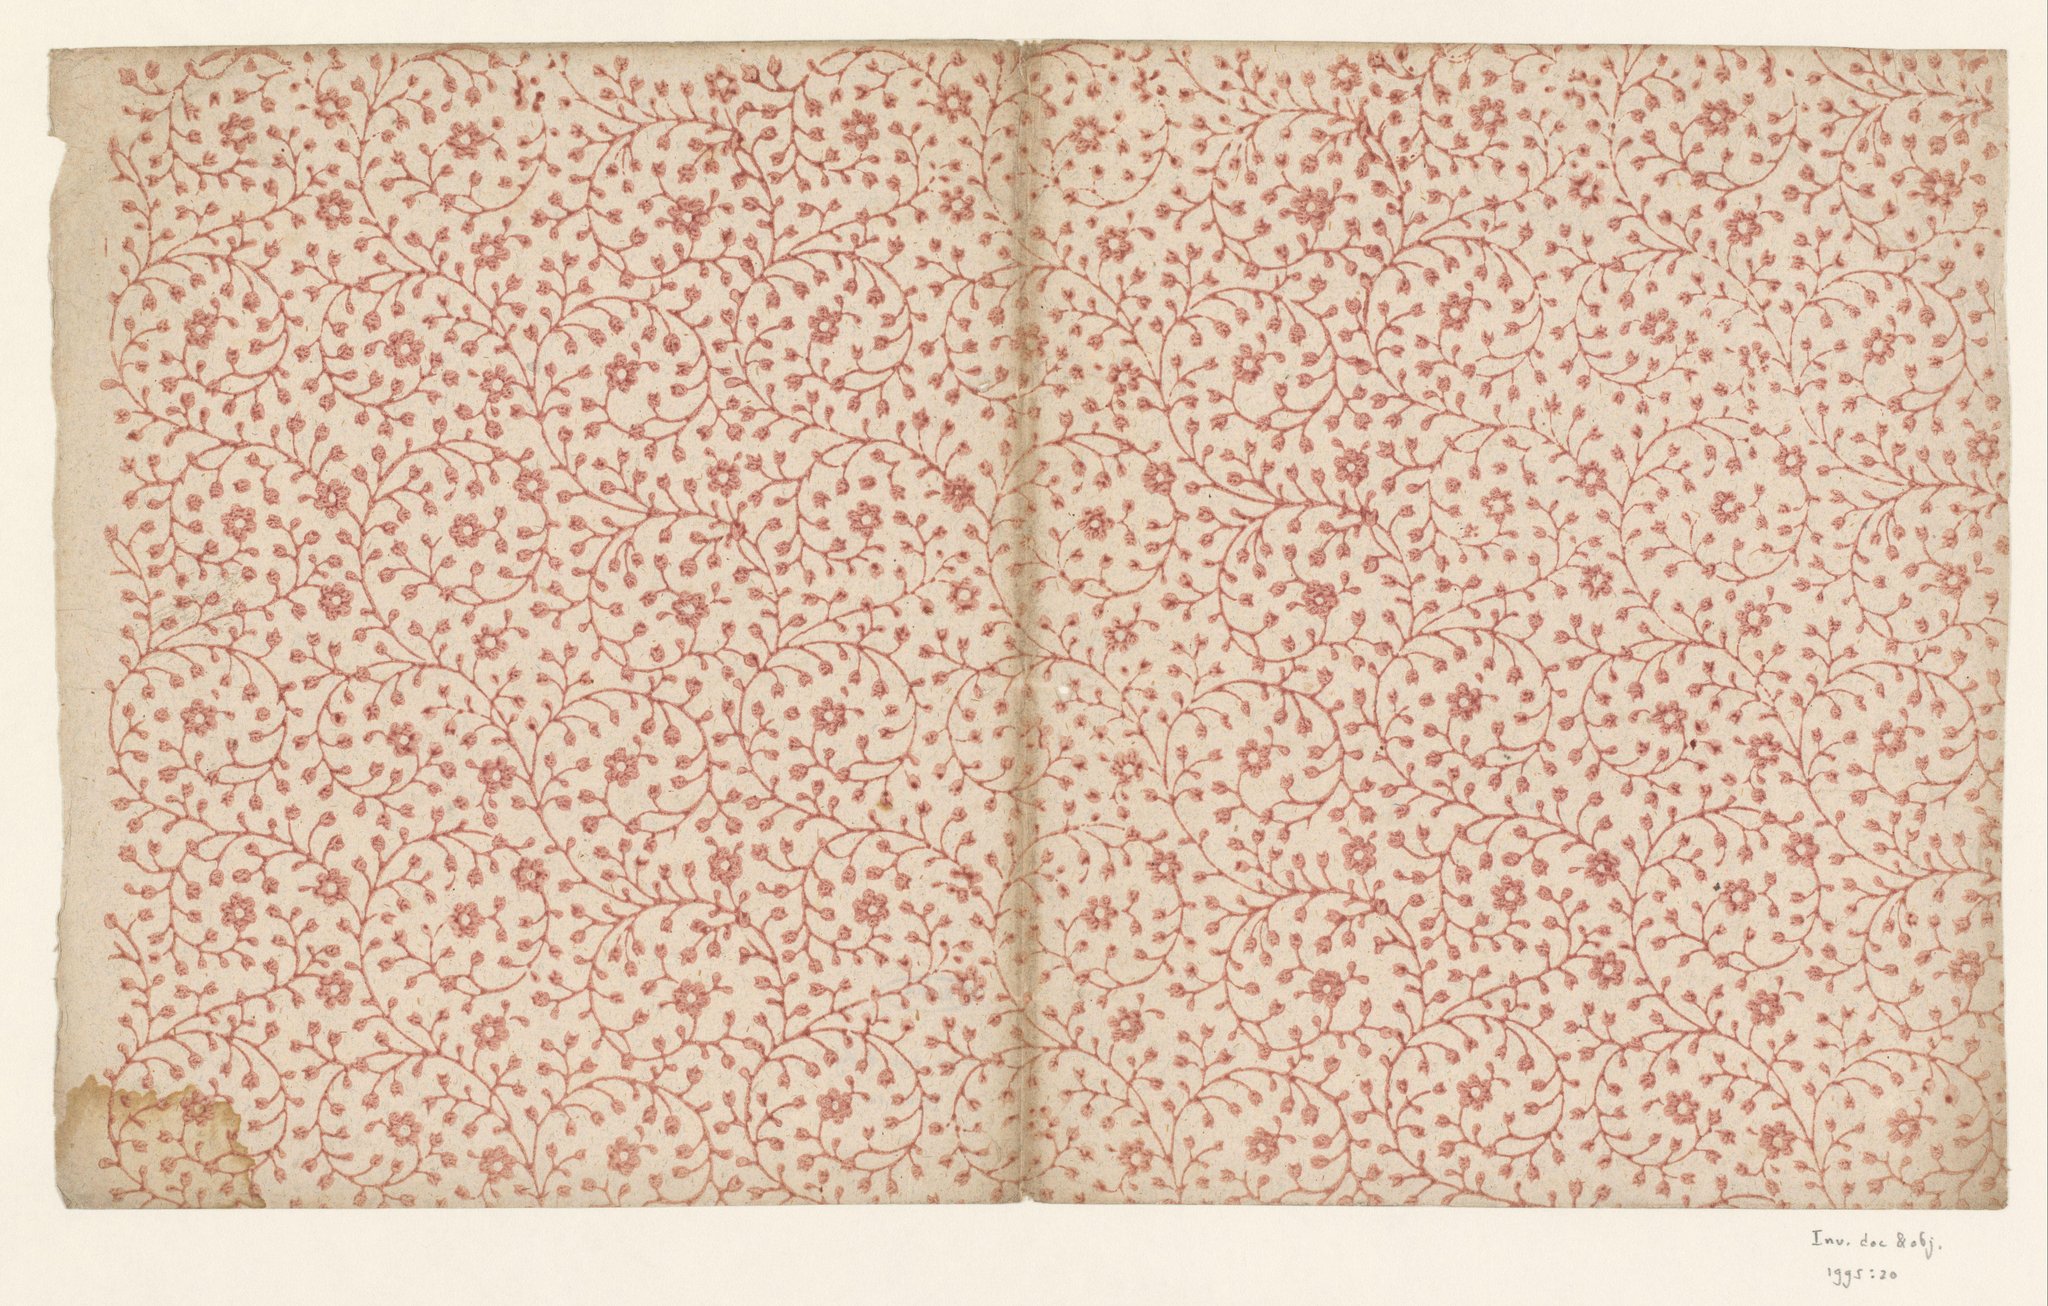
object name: printed paper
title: Blad met patroon van doorlopende ranken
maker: Anonymous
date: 1700-1850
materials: paper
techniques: printing block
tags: ornament derived from plant forms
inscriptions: collector's mark: Lugt 2228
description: Blad met patroon van doorlopende ranken met bloemen en knoppen.